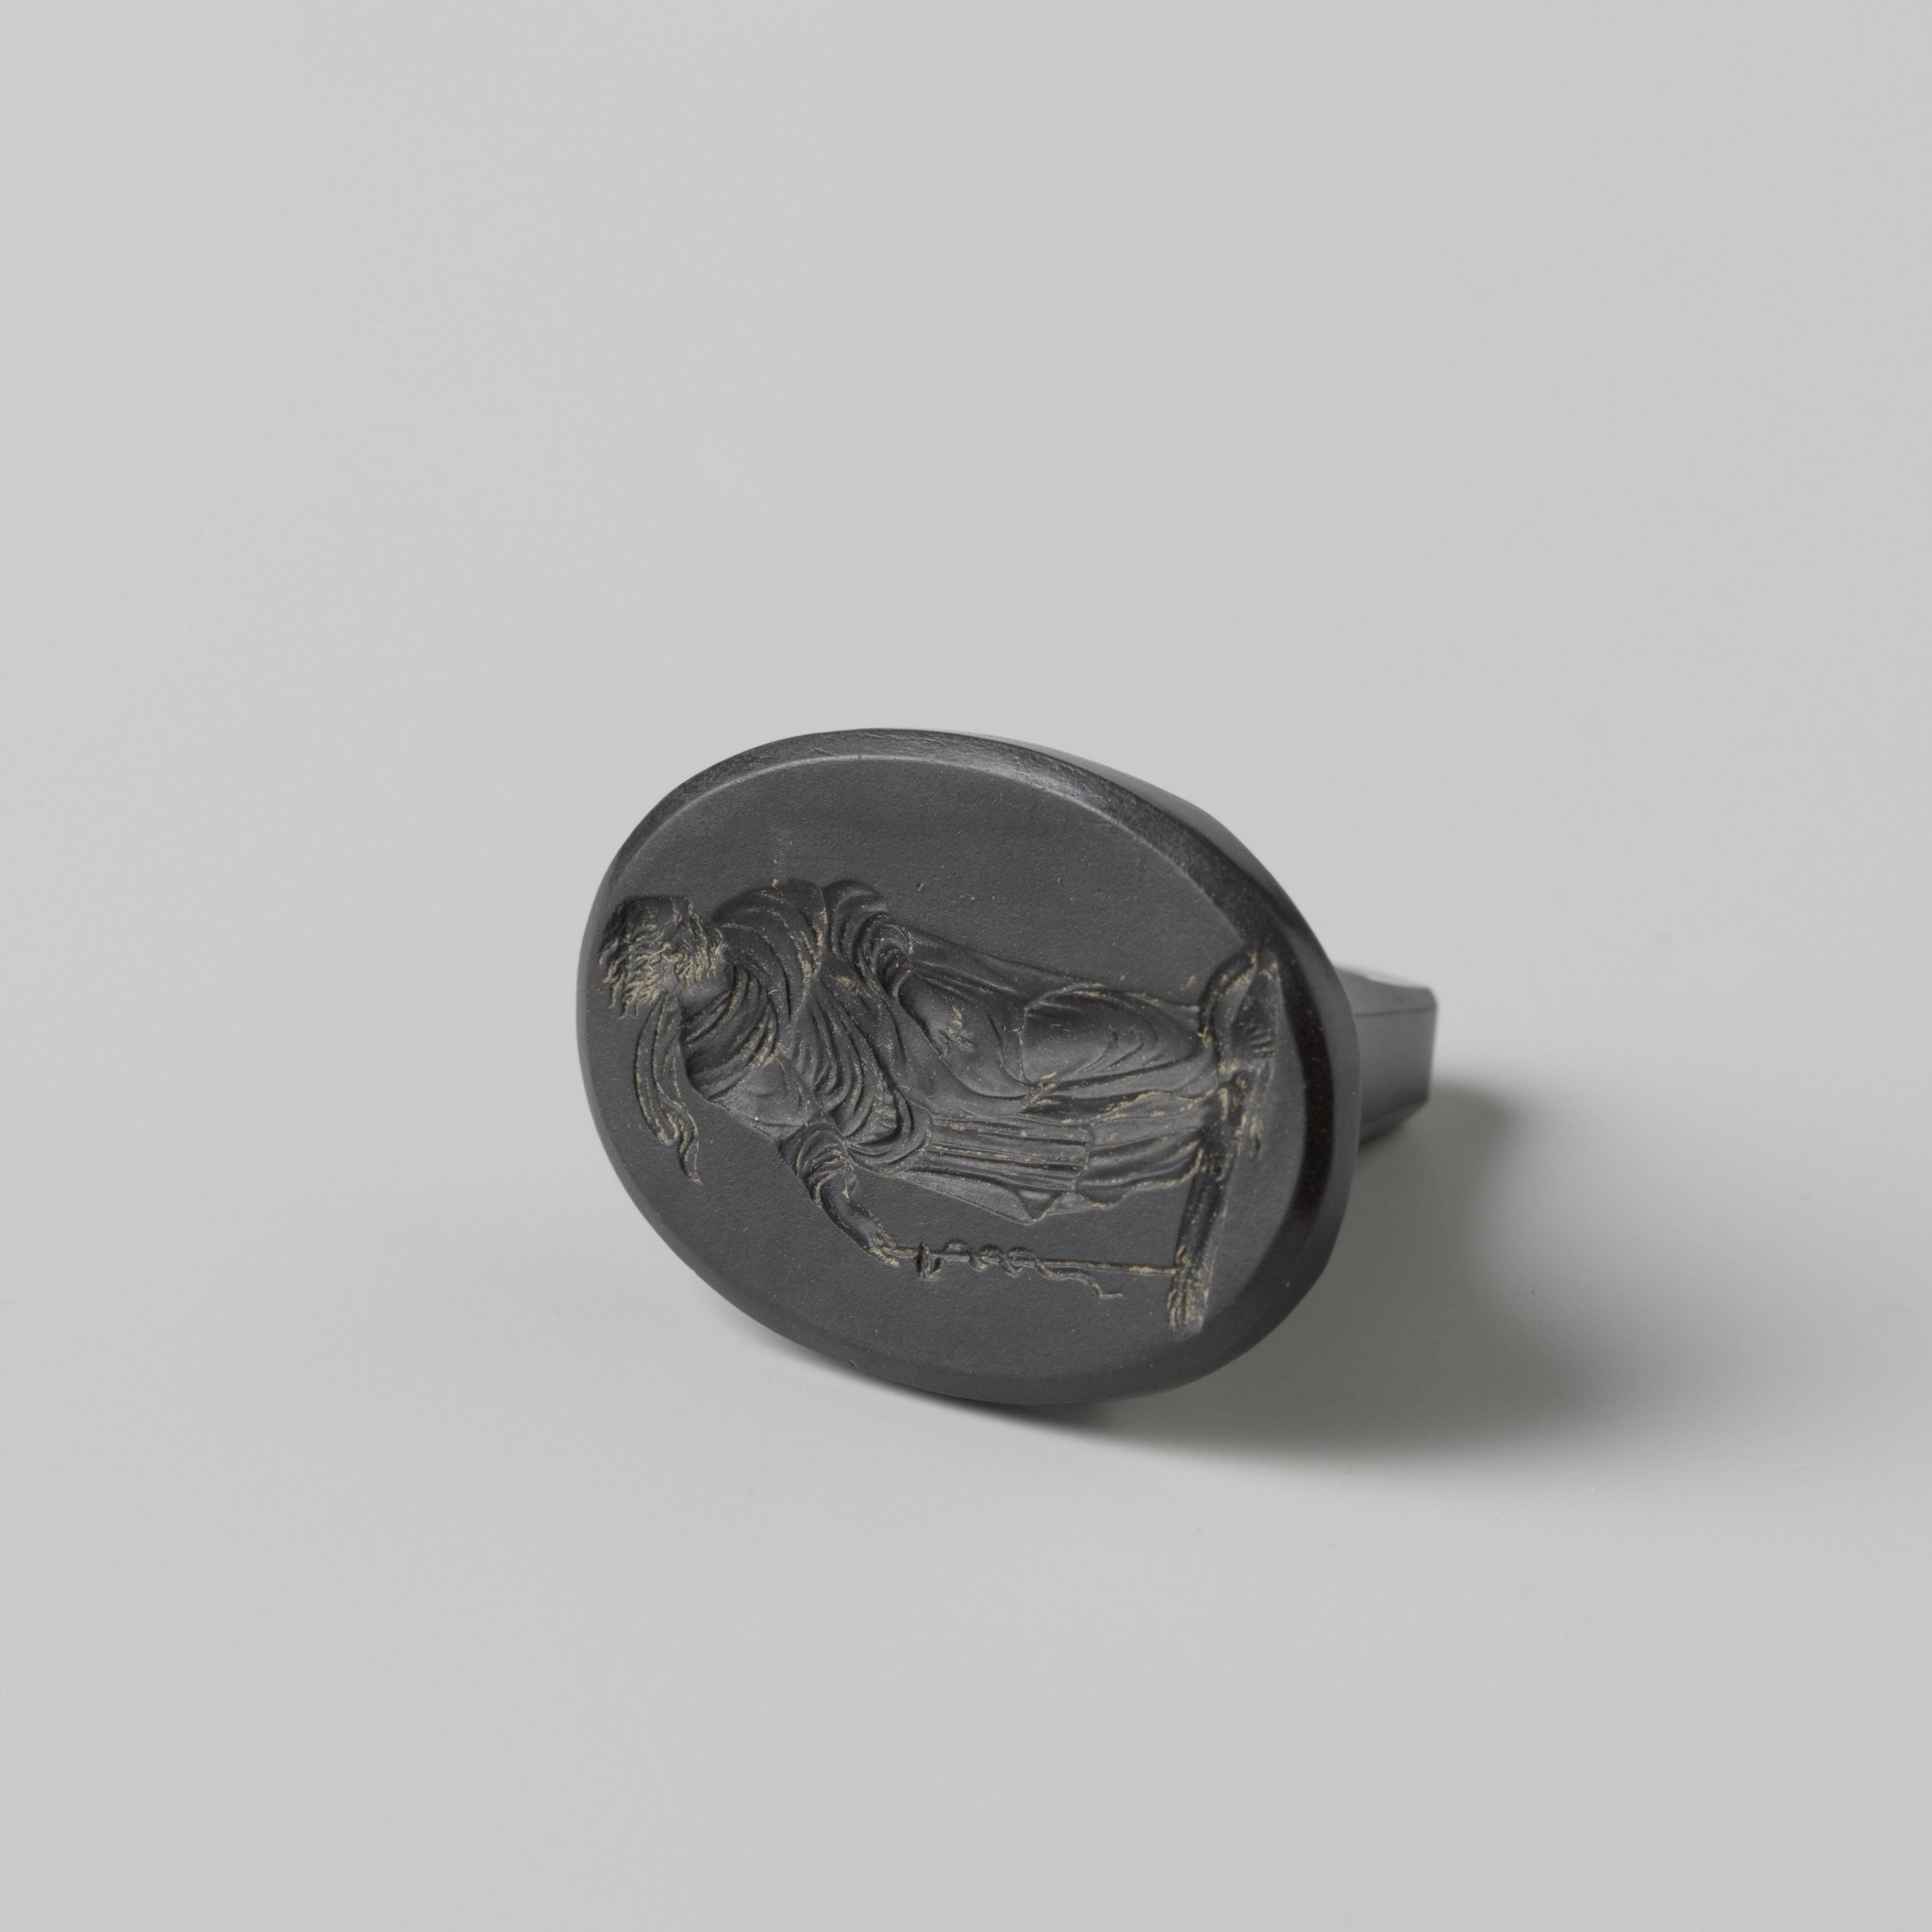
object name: stamp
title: Zegelstempel van zwart steengoed met een voorstelling van Esculaap de fabriek van Wedgwood en Bentley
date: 1788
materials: stoneware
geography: vicenza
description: Zegelstempel van zwart steengoed met een verdiepte voorstelling van Esculaap met slangenstaf. Aan de keerzijde achthoekig geslepen en kegelvormig oplopend. 'Basalt' uit de fabriek van Wedgwood en Bentley.